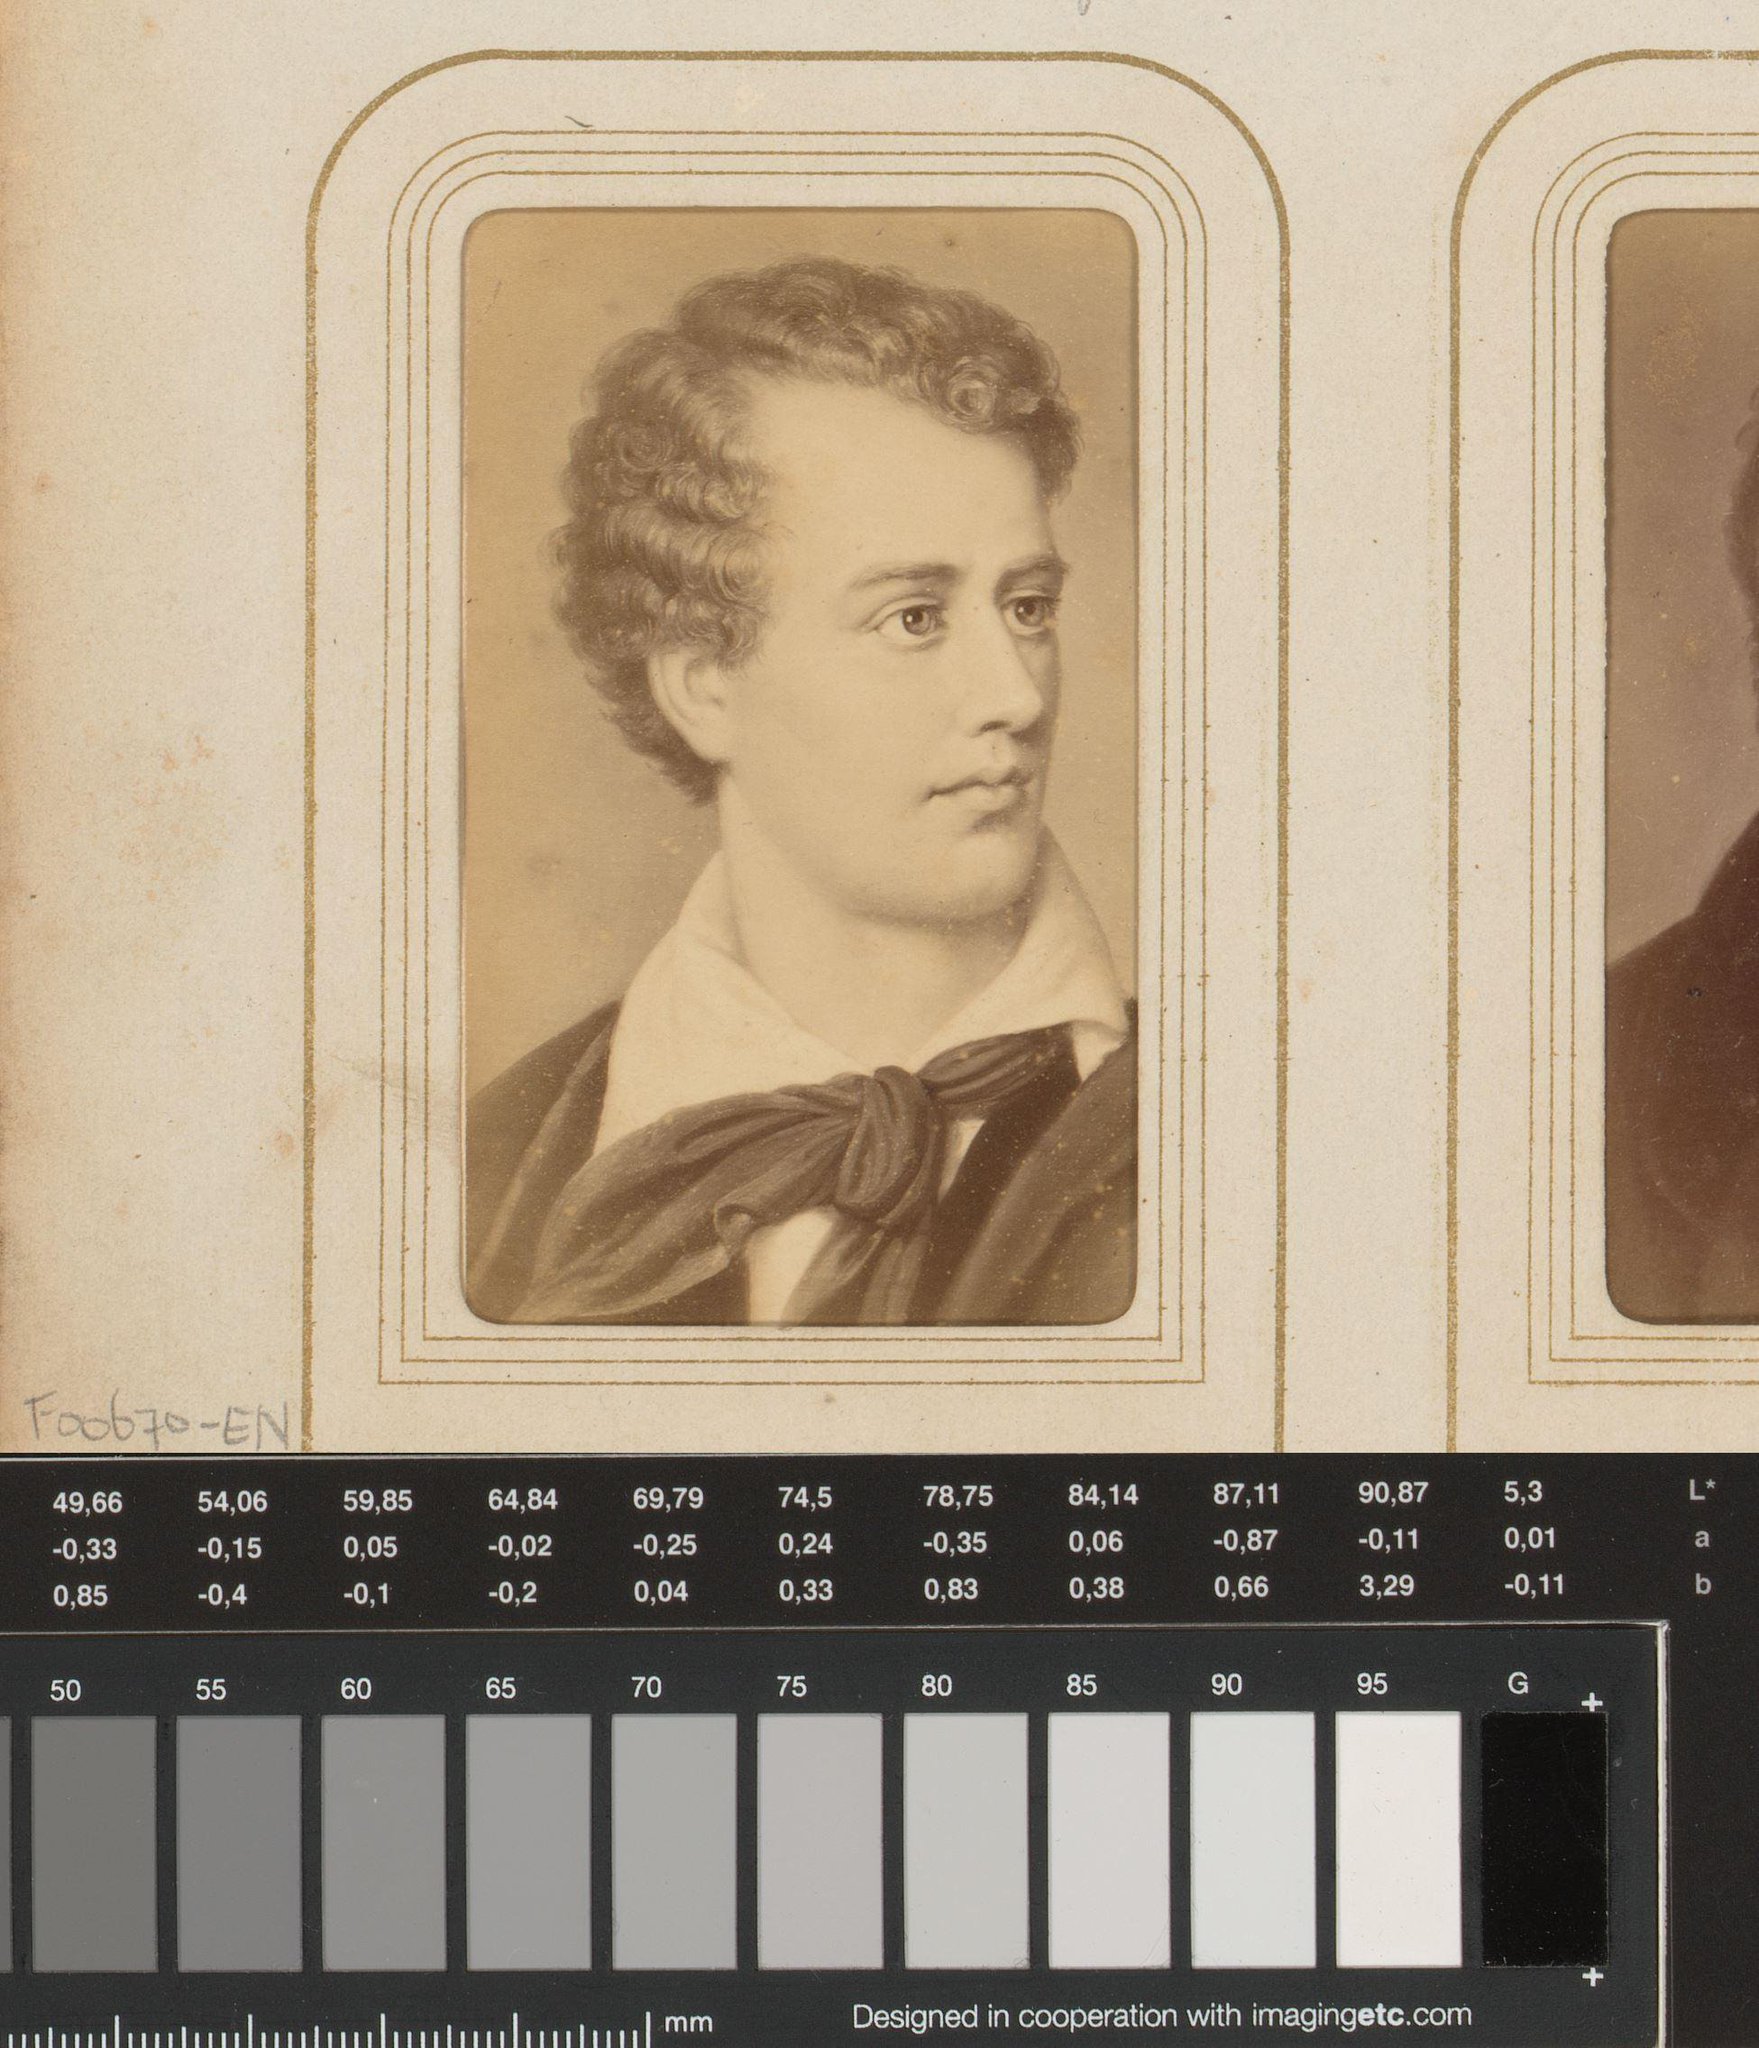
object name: reproduction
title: Fotoreproductie van een geschilderd portret van Lord Byron naar Ernst Hader door Sophus Williams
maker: sophus williams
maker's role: publisher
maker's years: 1835-1900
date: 1877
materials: cardboard, photographic support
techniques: albumen print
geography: berlin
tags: london, lord byron, historical persons, writer, poet, author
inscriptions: name: ‘Byron’, number: ‘1.50’